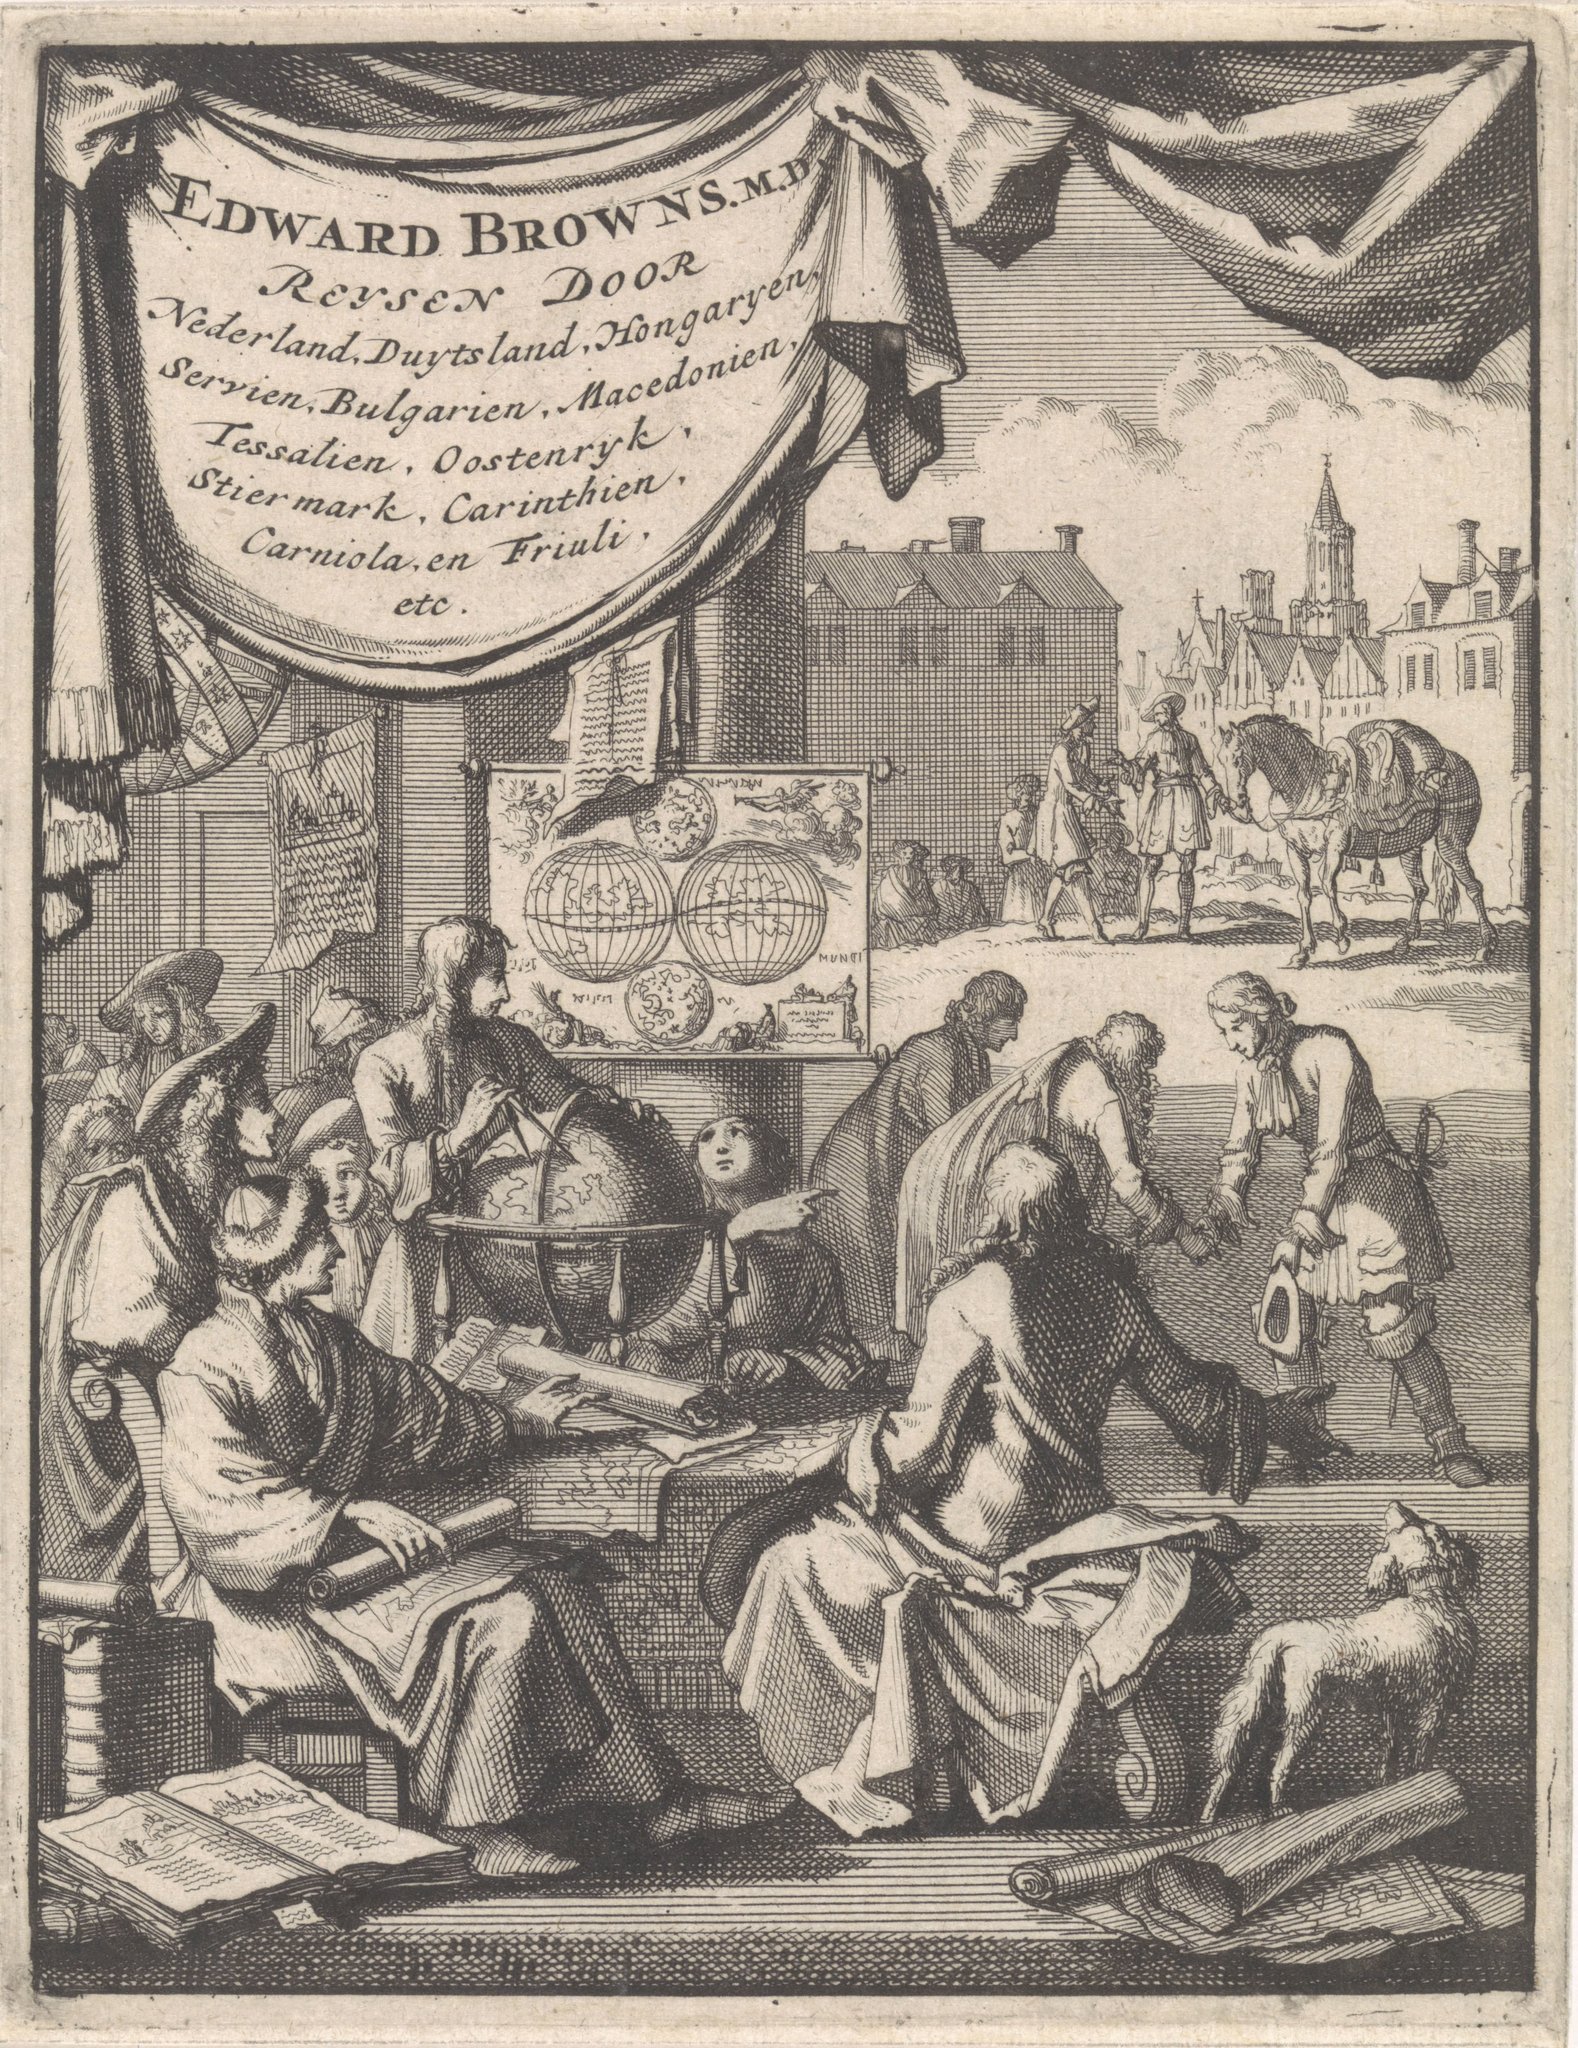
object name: print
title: Titelpagina voor: E. Browne, Naauwkeurige en gedenkwaardige reysen van Edward Brown, 1696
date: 1696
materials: paper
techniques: etching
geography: amsterdam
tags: group of scholars or philosophers, being welcomed ~ travelling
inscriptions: collector's mark: Lugt 2228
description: Titelpagina voor: Browne, Edward. Naauwkeurige en gedenkwaardige reysen van Edward Brown (...) door Nederland, Duytsland, Hongaryen. Amsterdam: Jan Claesz ten Hoorn, 1696.